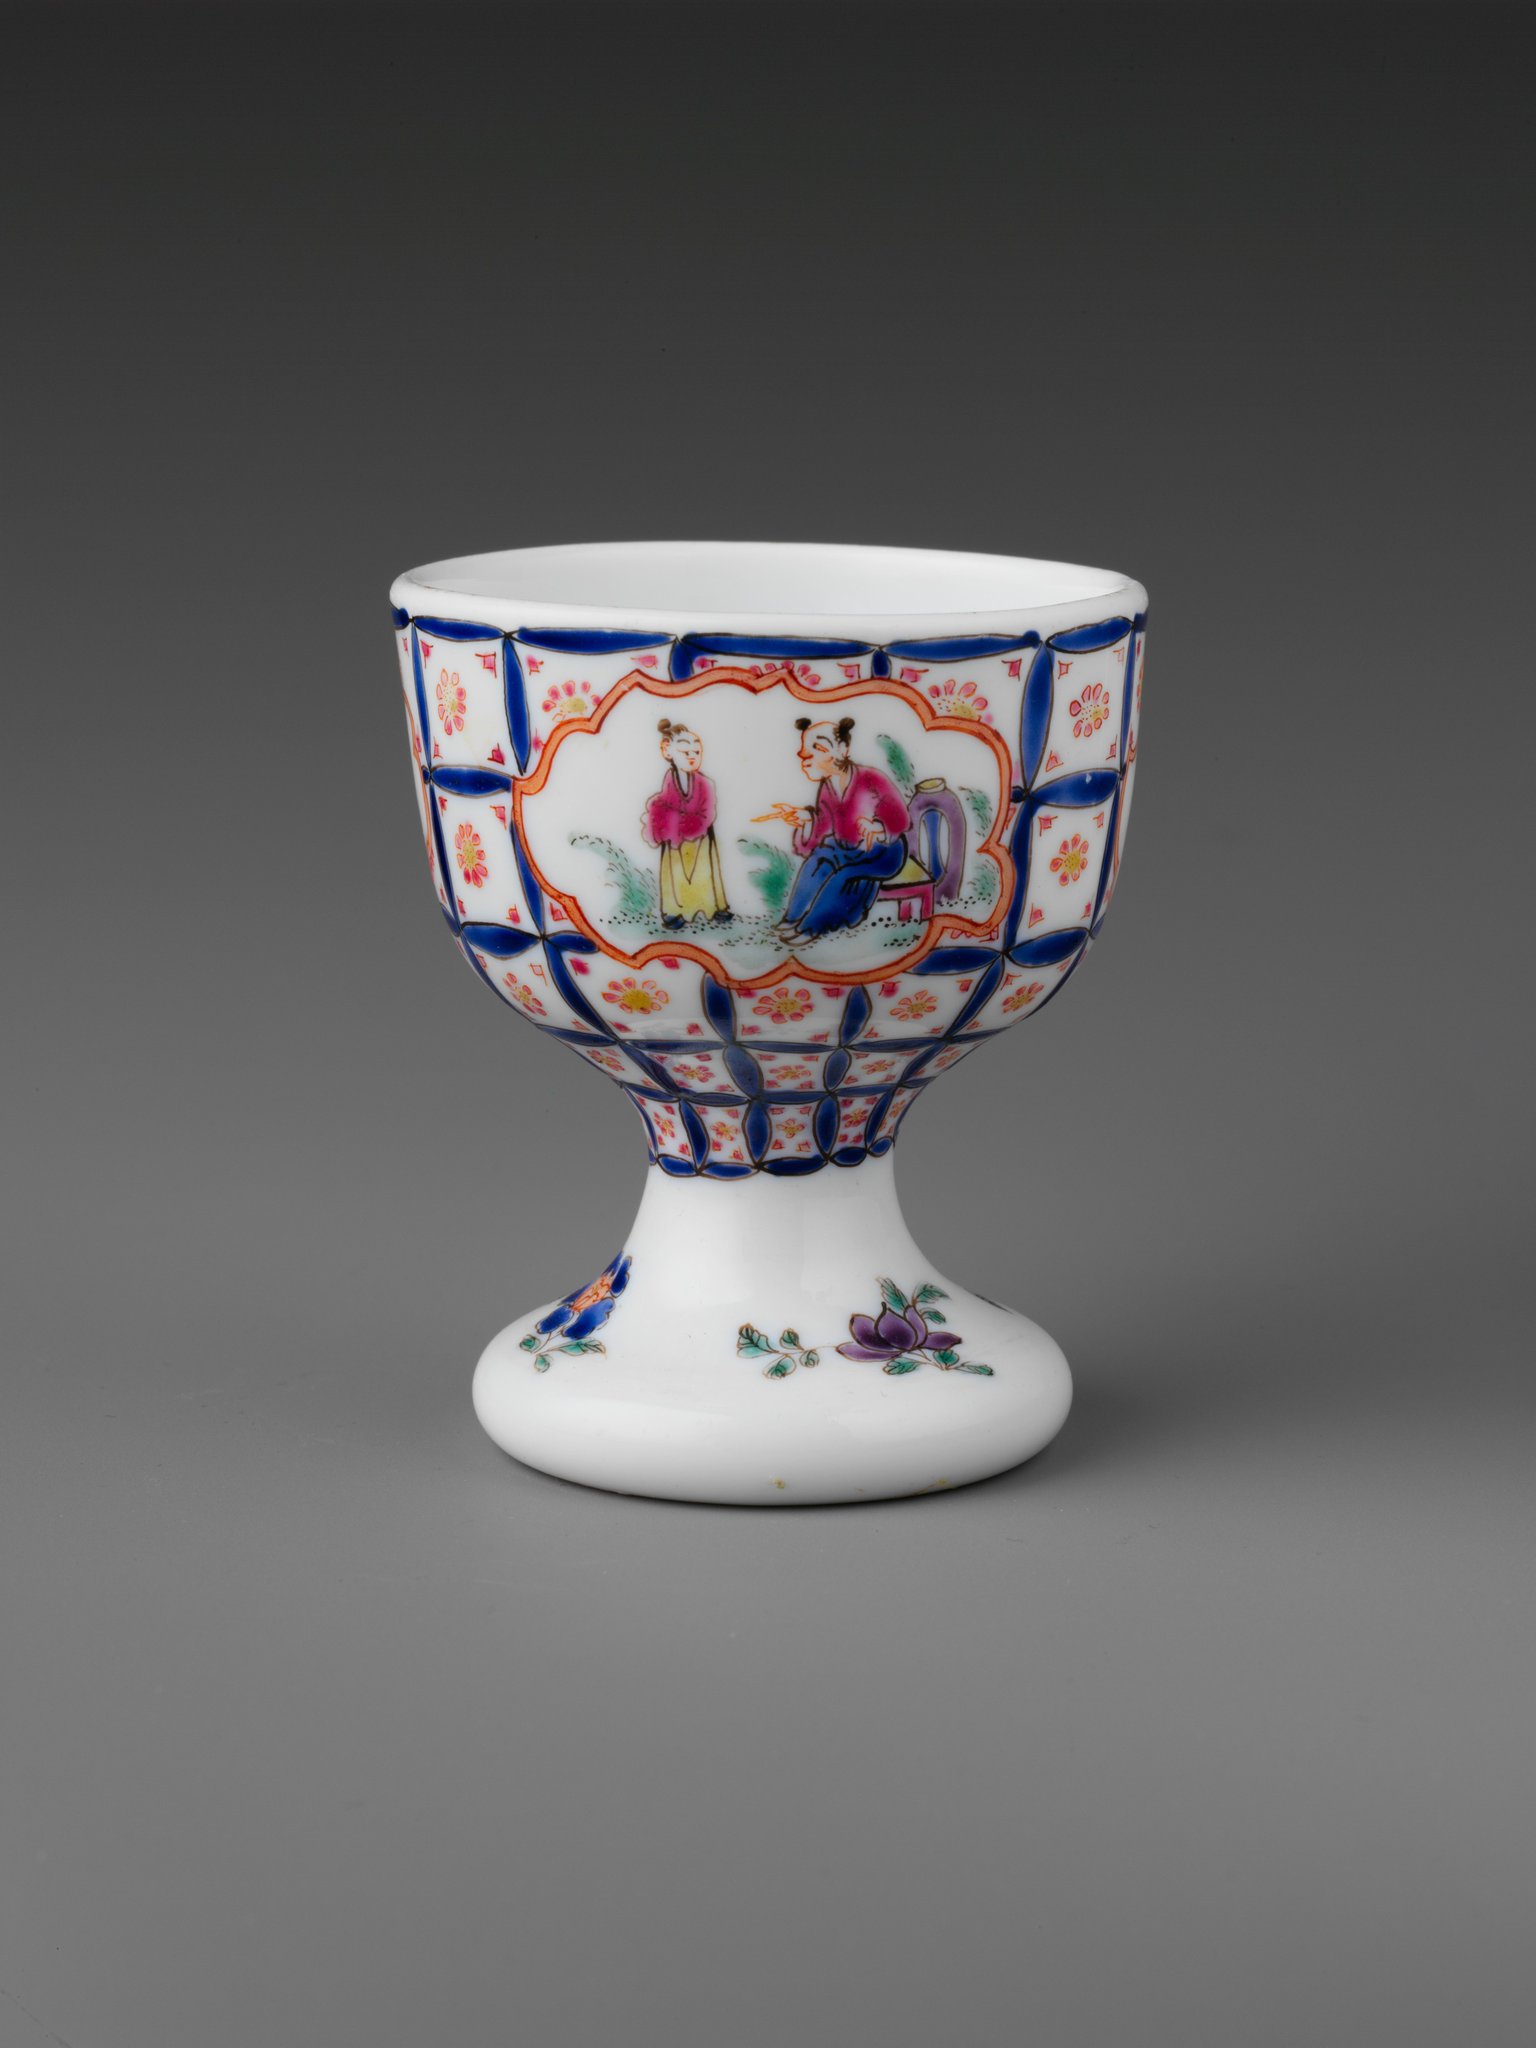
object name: egg cup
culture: british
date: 1760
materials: enamel, glass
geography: england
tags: human figures,dogs,flowers